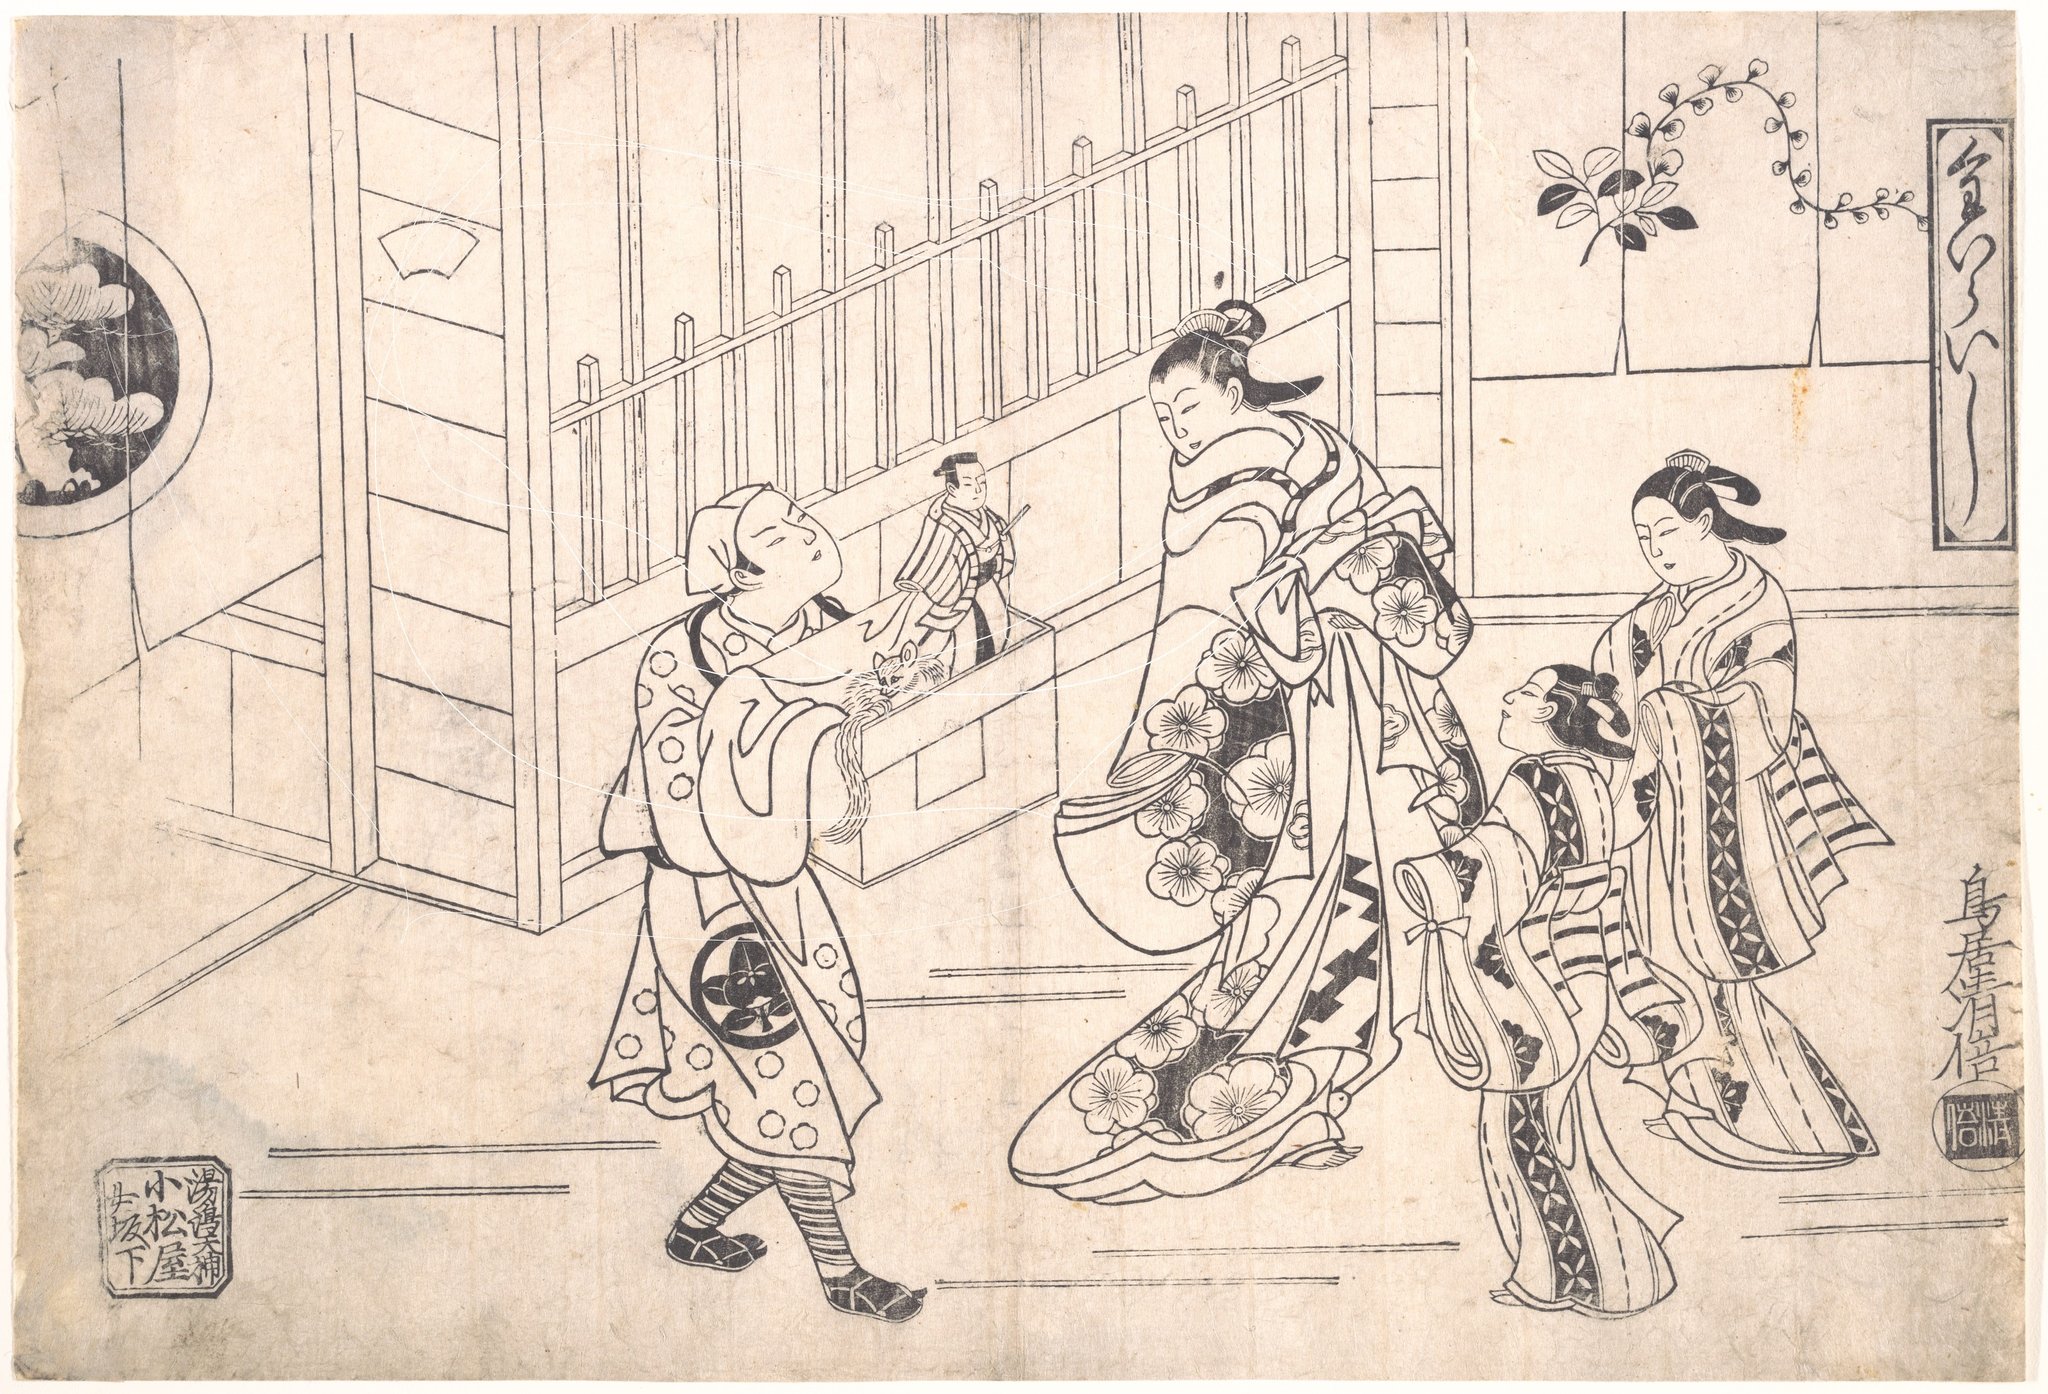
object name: print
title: The Actor Ichimura Takenojo VIII in the Role of a Puppeteer, showing Puppets to a Courtesan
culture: japanese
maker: torii kiyomasu i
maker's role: artist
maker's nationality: japanese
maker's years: 1696-1716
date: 1715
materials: ink, paper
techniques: woodblock print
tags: men,women,actors,puppets